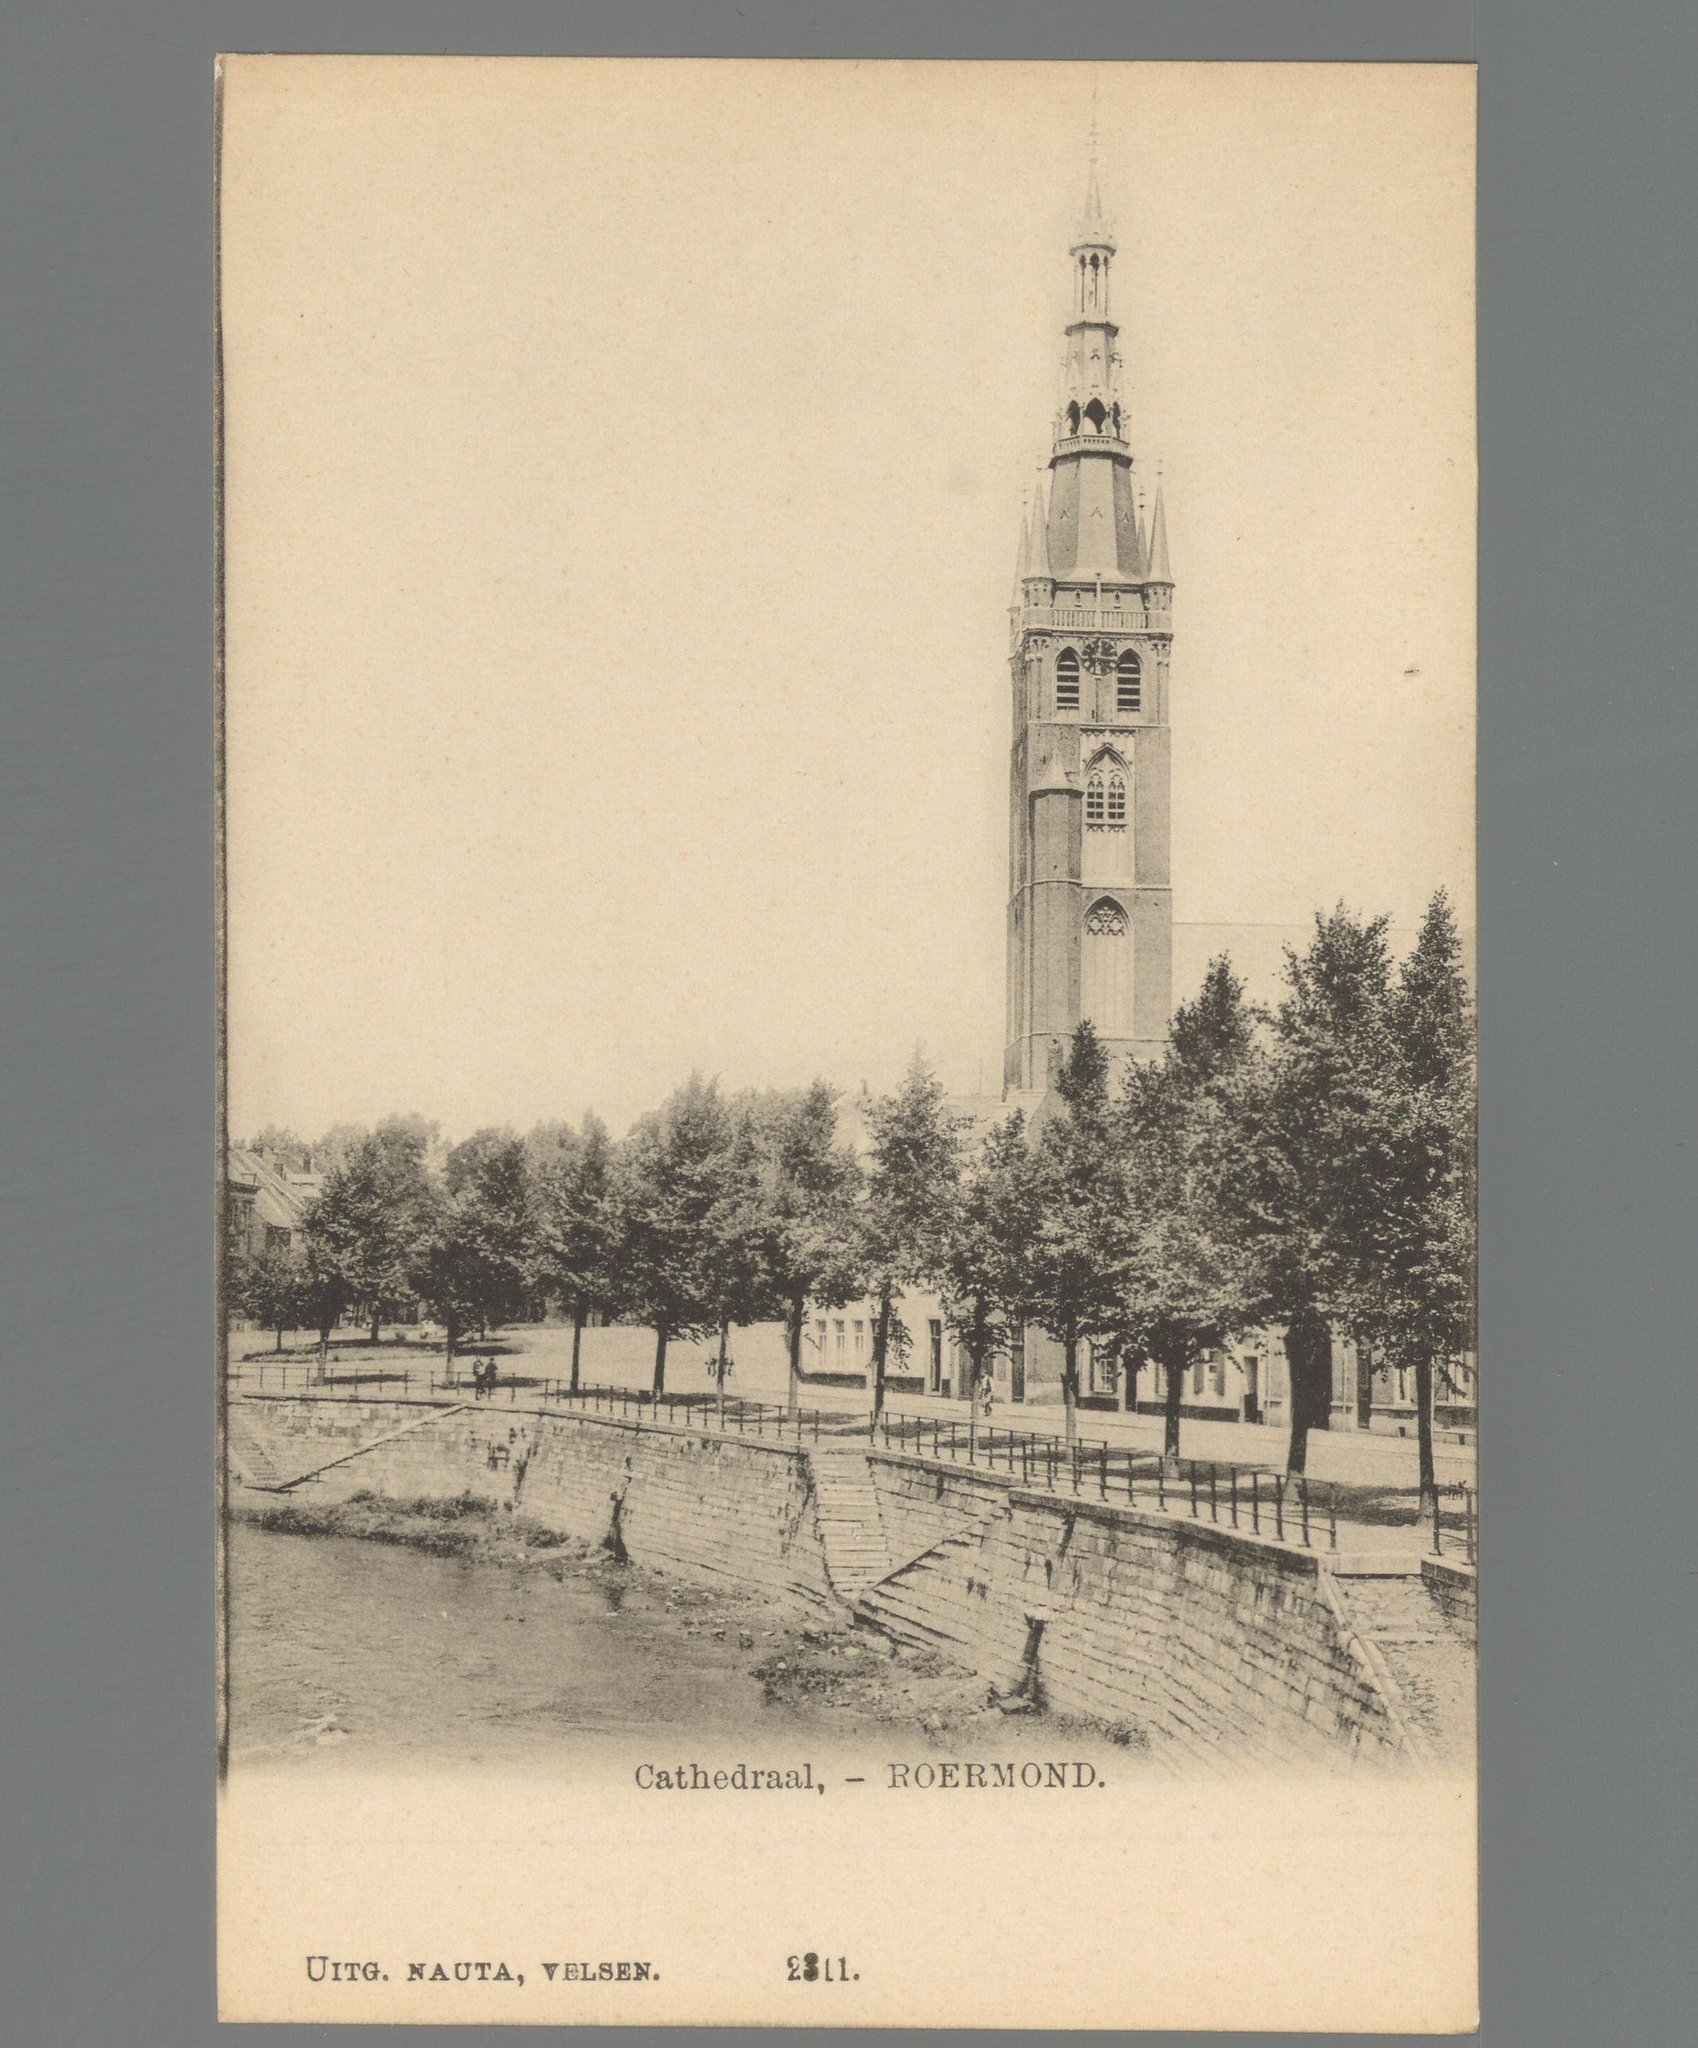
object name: photomechanical print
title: Cathedraal, - Roermond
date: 1897-1905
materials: cardboard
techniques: photograph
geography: roermond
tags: church (exterior)